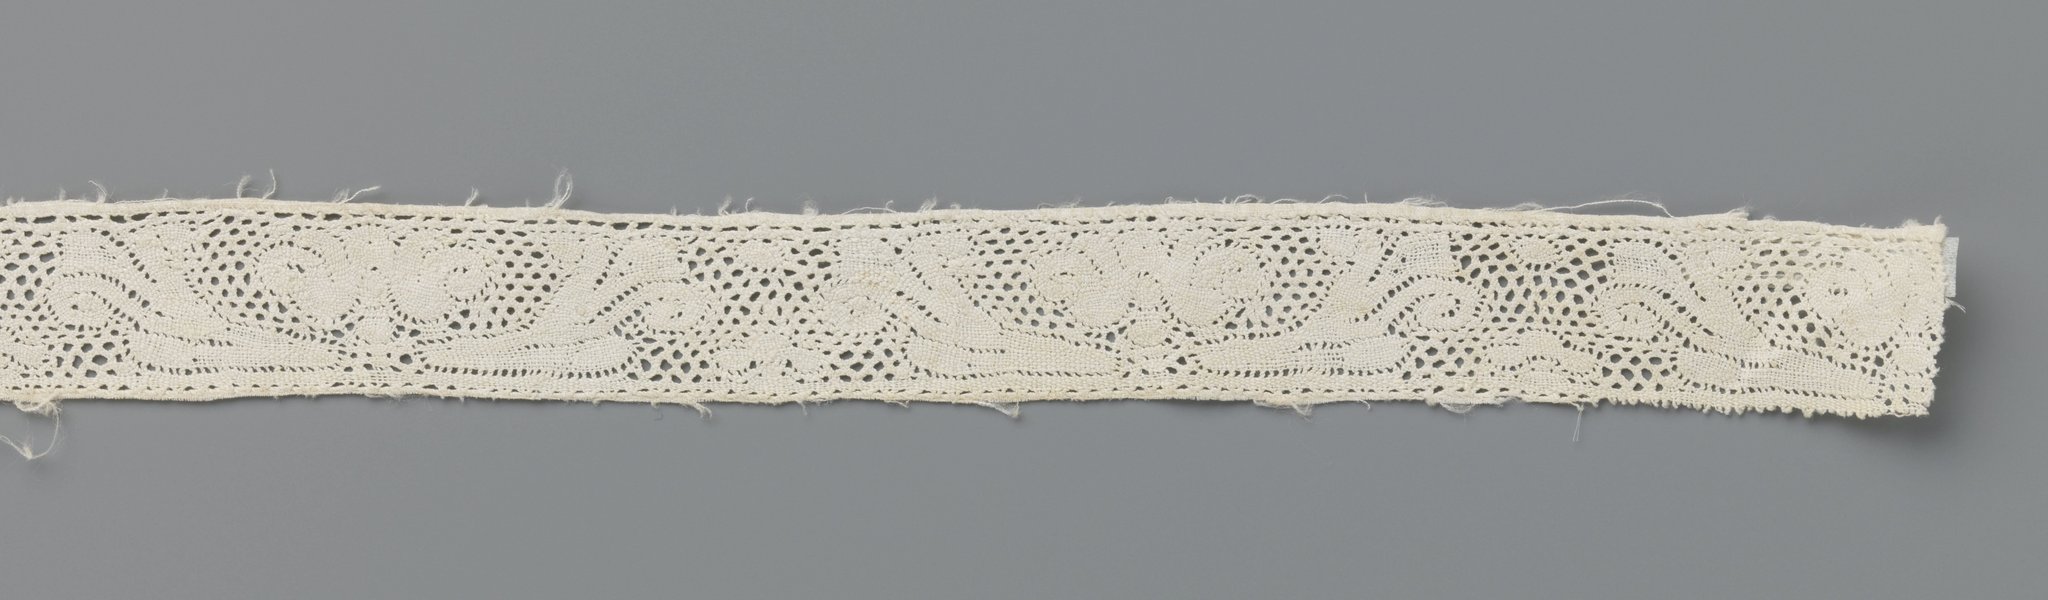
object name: entre deux, tussenzetsel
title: Tussenzetsel van kloskant met bloem tussen langgerekte voluutbladeren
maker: Anonymous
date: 1650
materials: linen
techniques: lace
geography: antwerp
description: Tussenzetsel van naturelkleurige Hollanse kloskant. Het patroon bestaat uit een zich herhalend symmetrisch motief van een bloem tussen langgerekte voluutbladeren. De motieven zijn gemaakt in linnenslag met opengewerkte randjes en zijn met elkaar verbonden door een min of meer ronde traliegrond met vlechtslagen. De boven- en onderzijde zijn recht afgewerkt. Het tussenzetsel is met enkele grove steken aan eenzelfde strook kloskant genaaid.